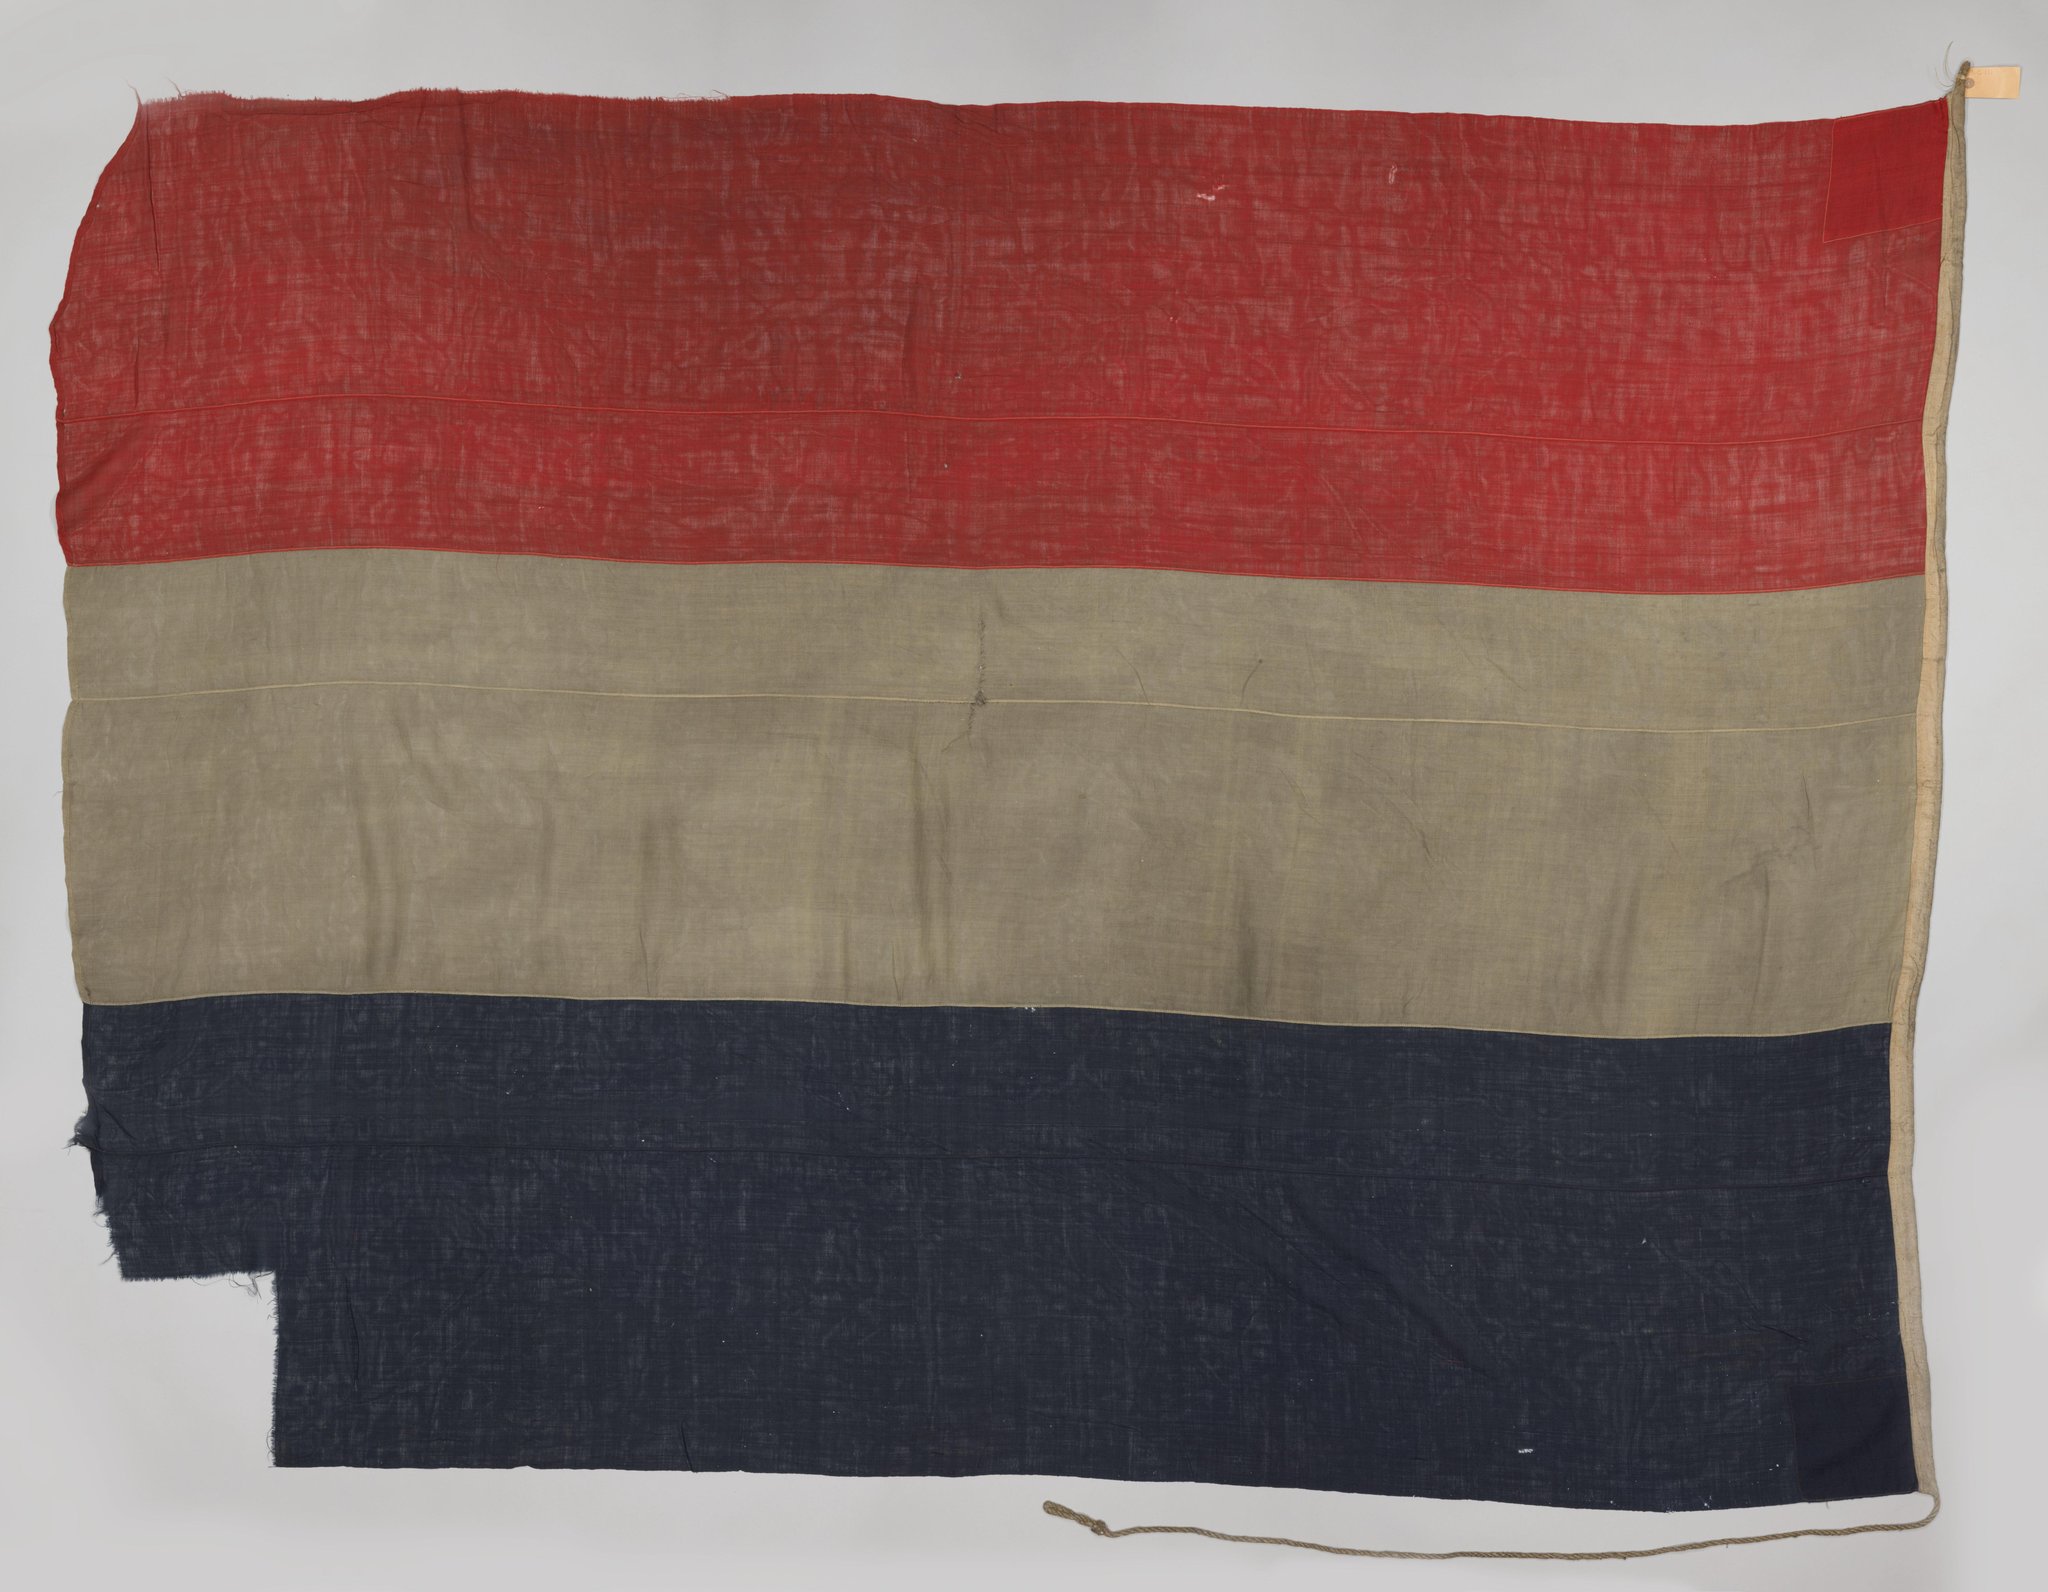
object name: ship flag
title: Scheepsvlag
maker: Anonymous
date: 1800-1890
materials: wool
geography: netherlands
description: Drie banen rood-wit-blauw. Opschrift: NED VL 4«KD.